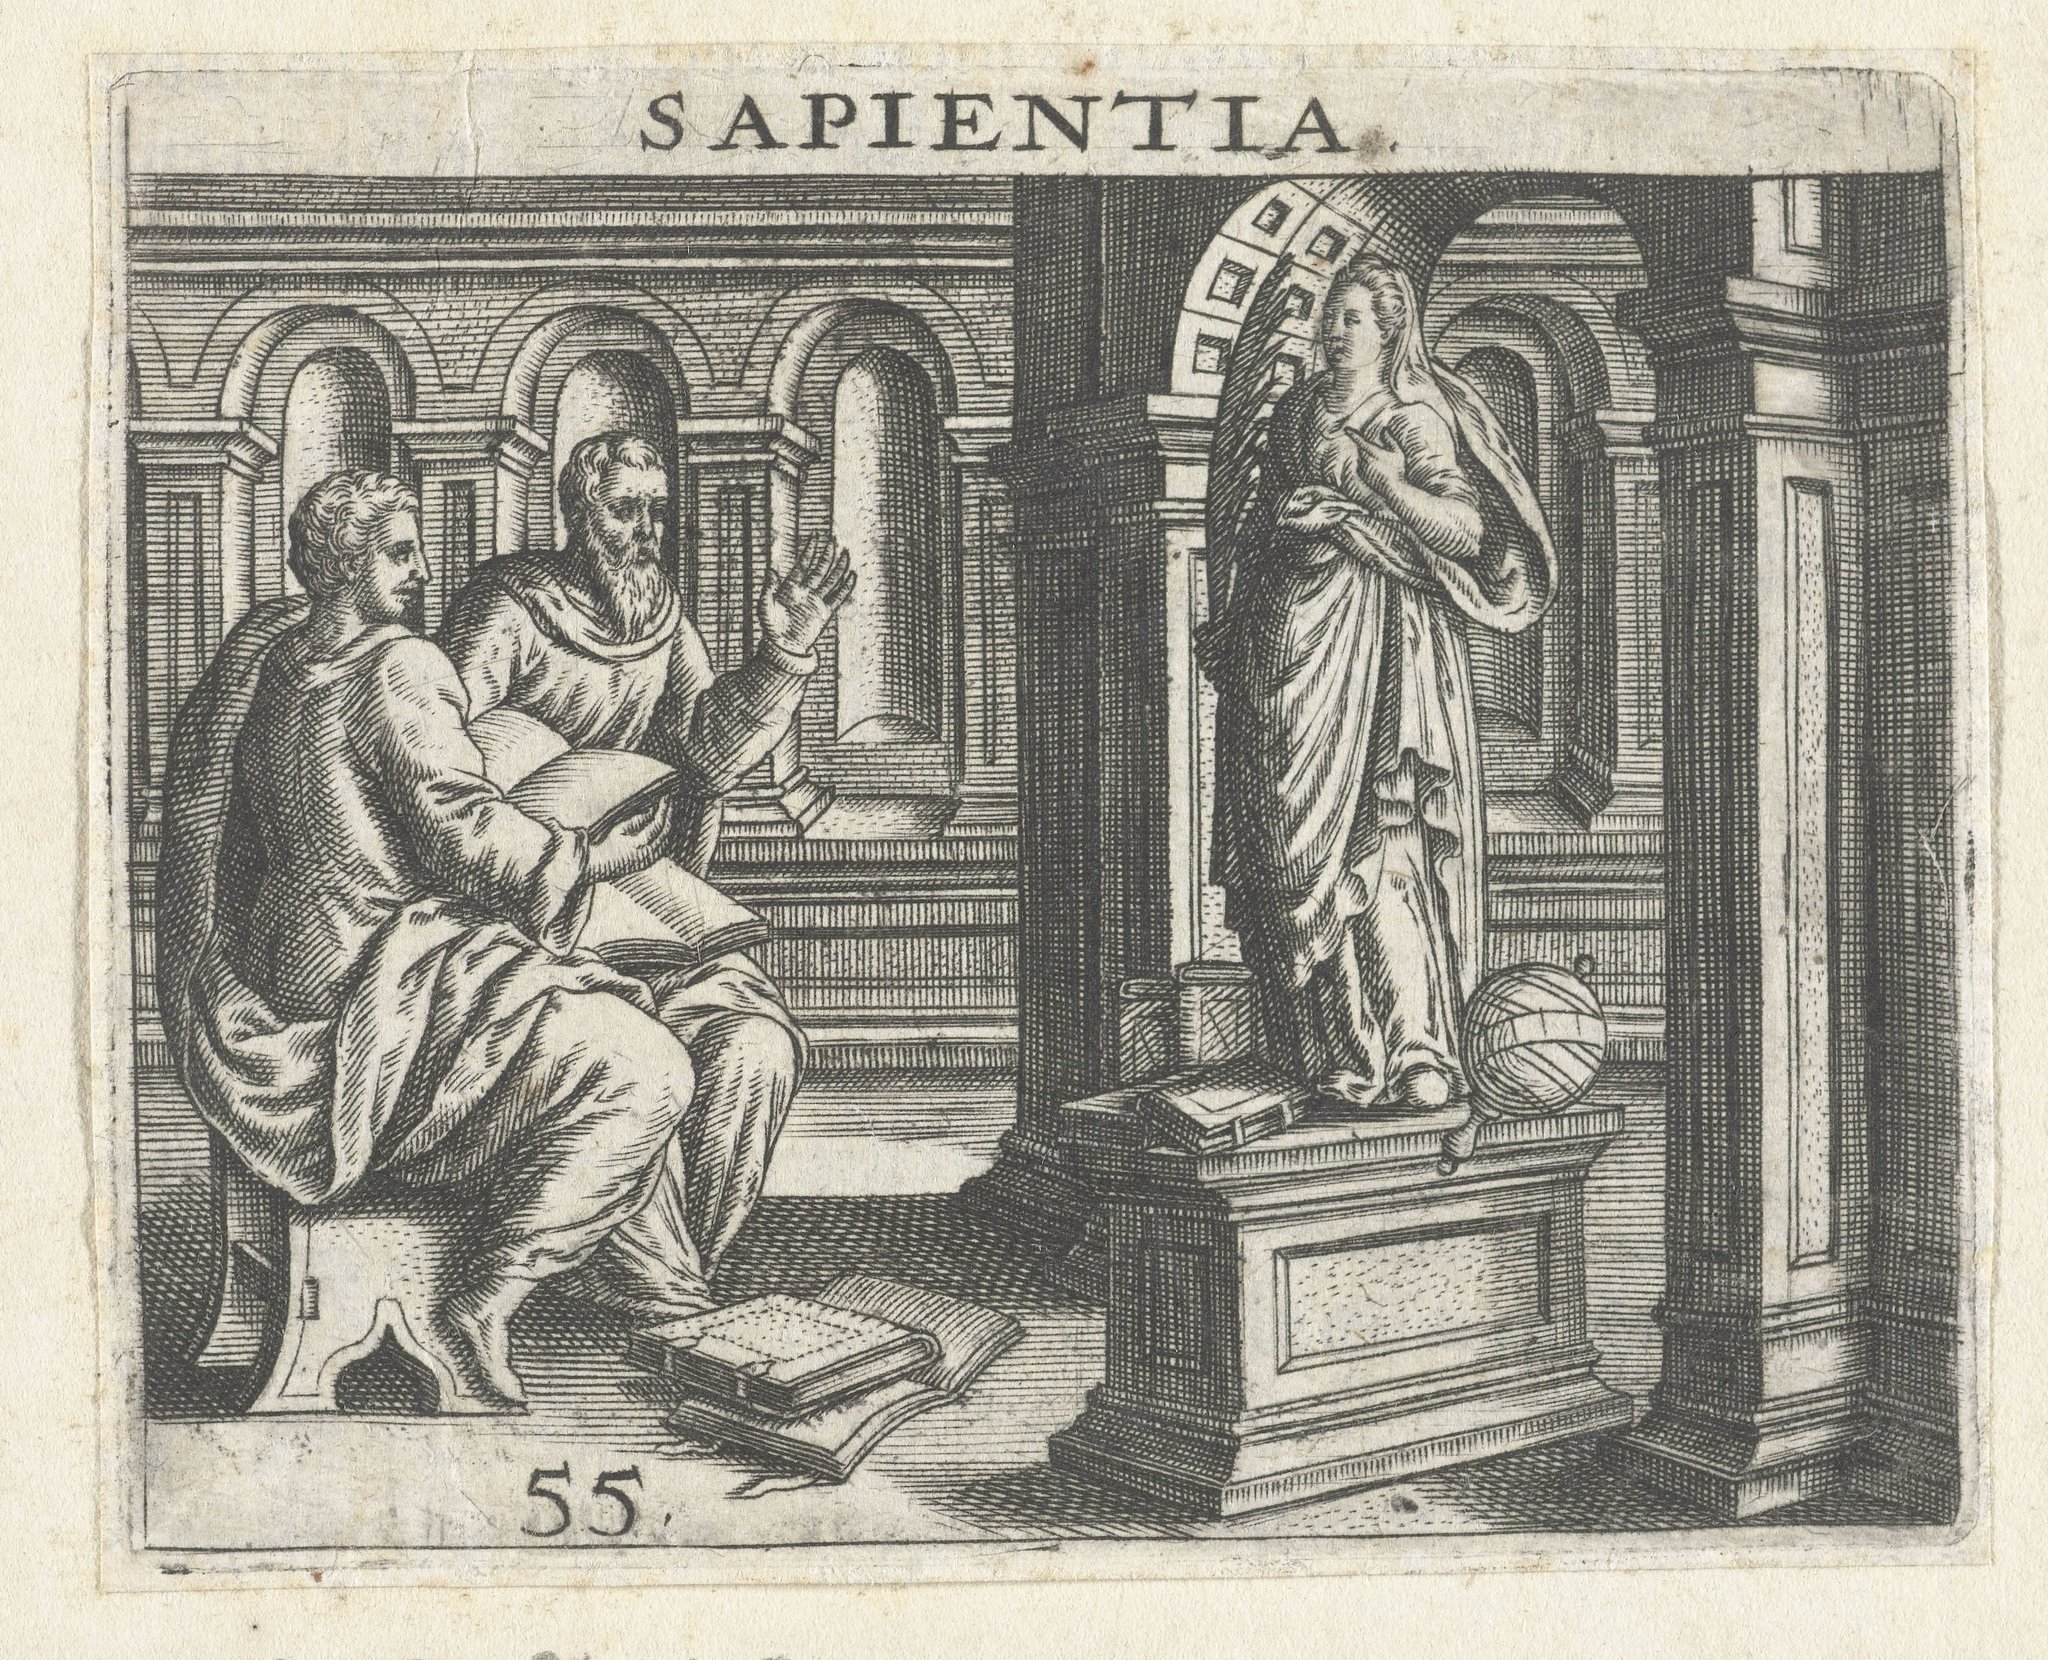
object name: print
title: Denis Lebey de Batilly, Emblemata, 1596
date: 1596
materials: paper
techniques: engraving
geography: frankfurt am main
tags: wisdom; 'sapienza', 'sapienza humana', 'sapienza vera' (ripa), group of scholars or philosophers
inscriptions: collector's mark: Lugt 240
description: Twee geleerden zitten over hun boeken. Naast hen staat een beeld van de Wijsheid, een vrouw met een palmtak in haar hand en meetinstrumenten en boeken aan haar voeten.